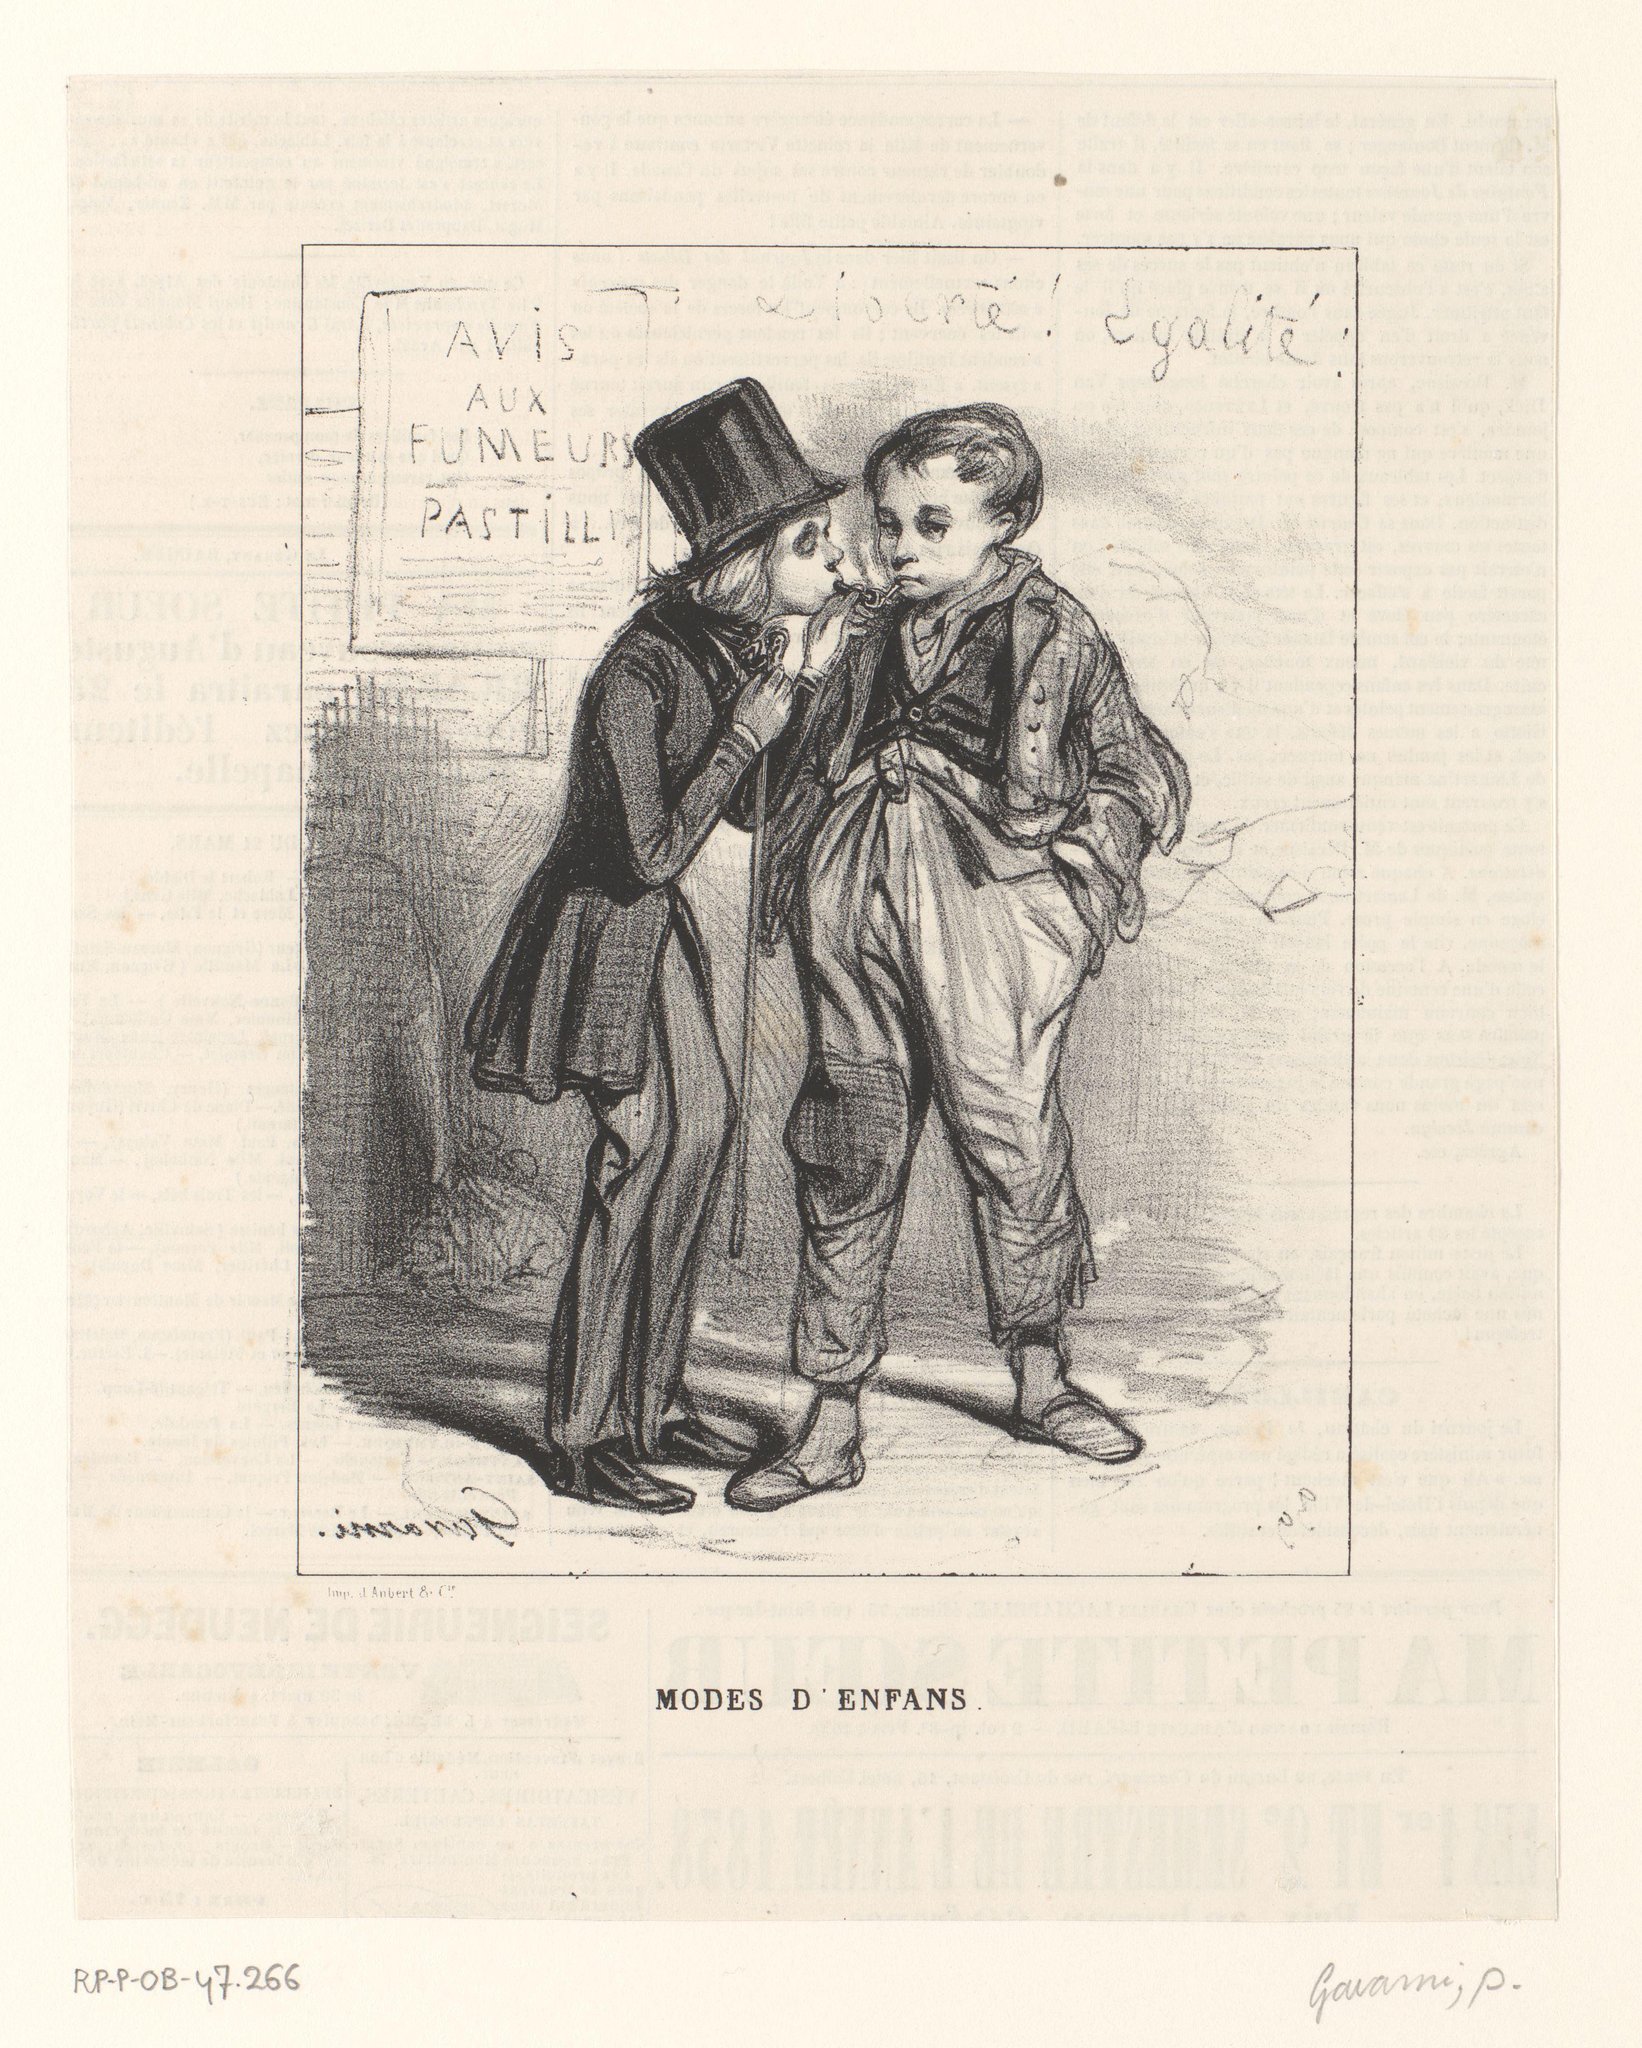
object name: print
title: Modes d'enfans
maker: paul gavarni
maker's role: draughtsman, print maker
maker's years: 1804-1866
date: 1839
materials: paper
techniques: lithograph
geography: paris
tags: mischief-making play, boy (child between toddler and youth), children behaving like adults, tobacco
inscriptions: collector's mark: Lugt 2228a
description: Prent gebruikt voor: Le Charivari, 21 maart 1839.